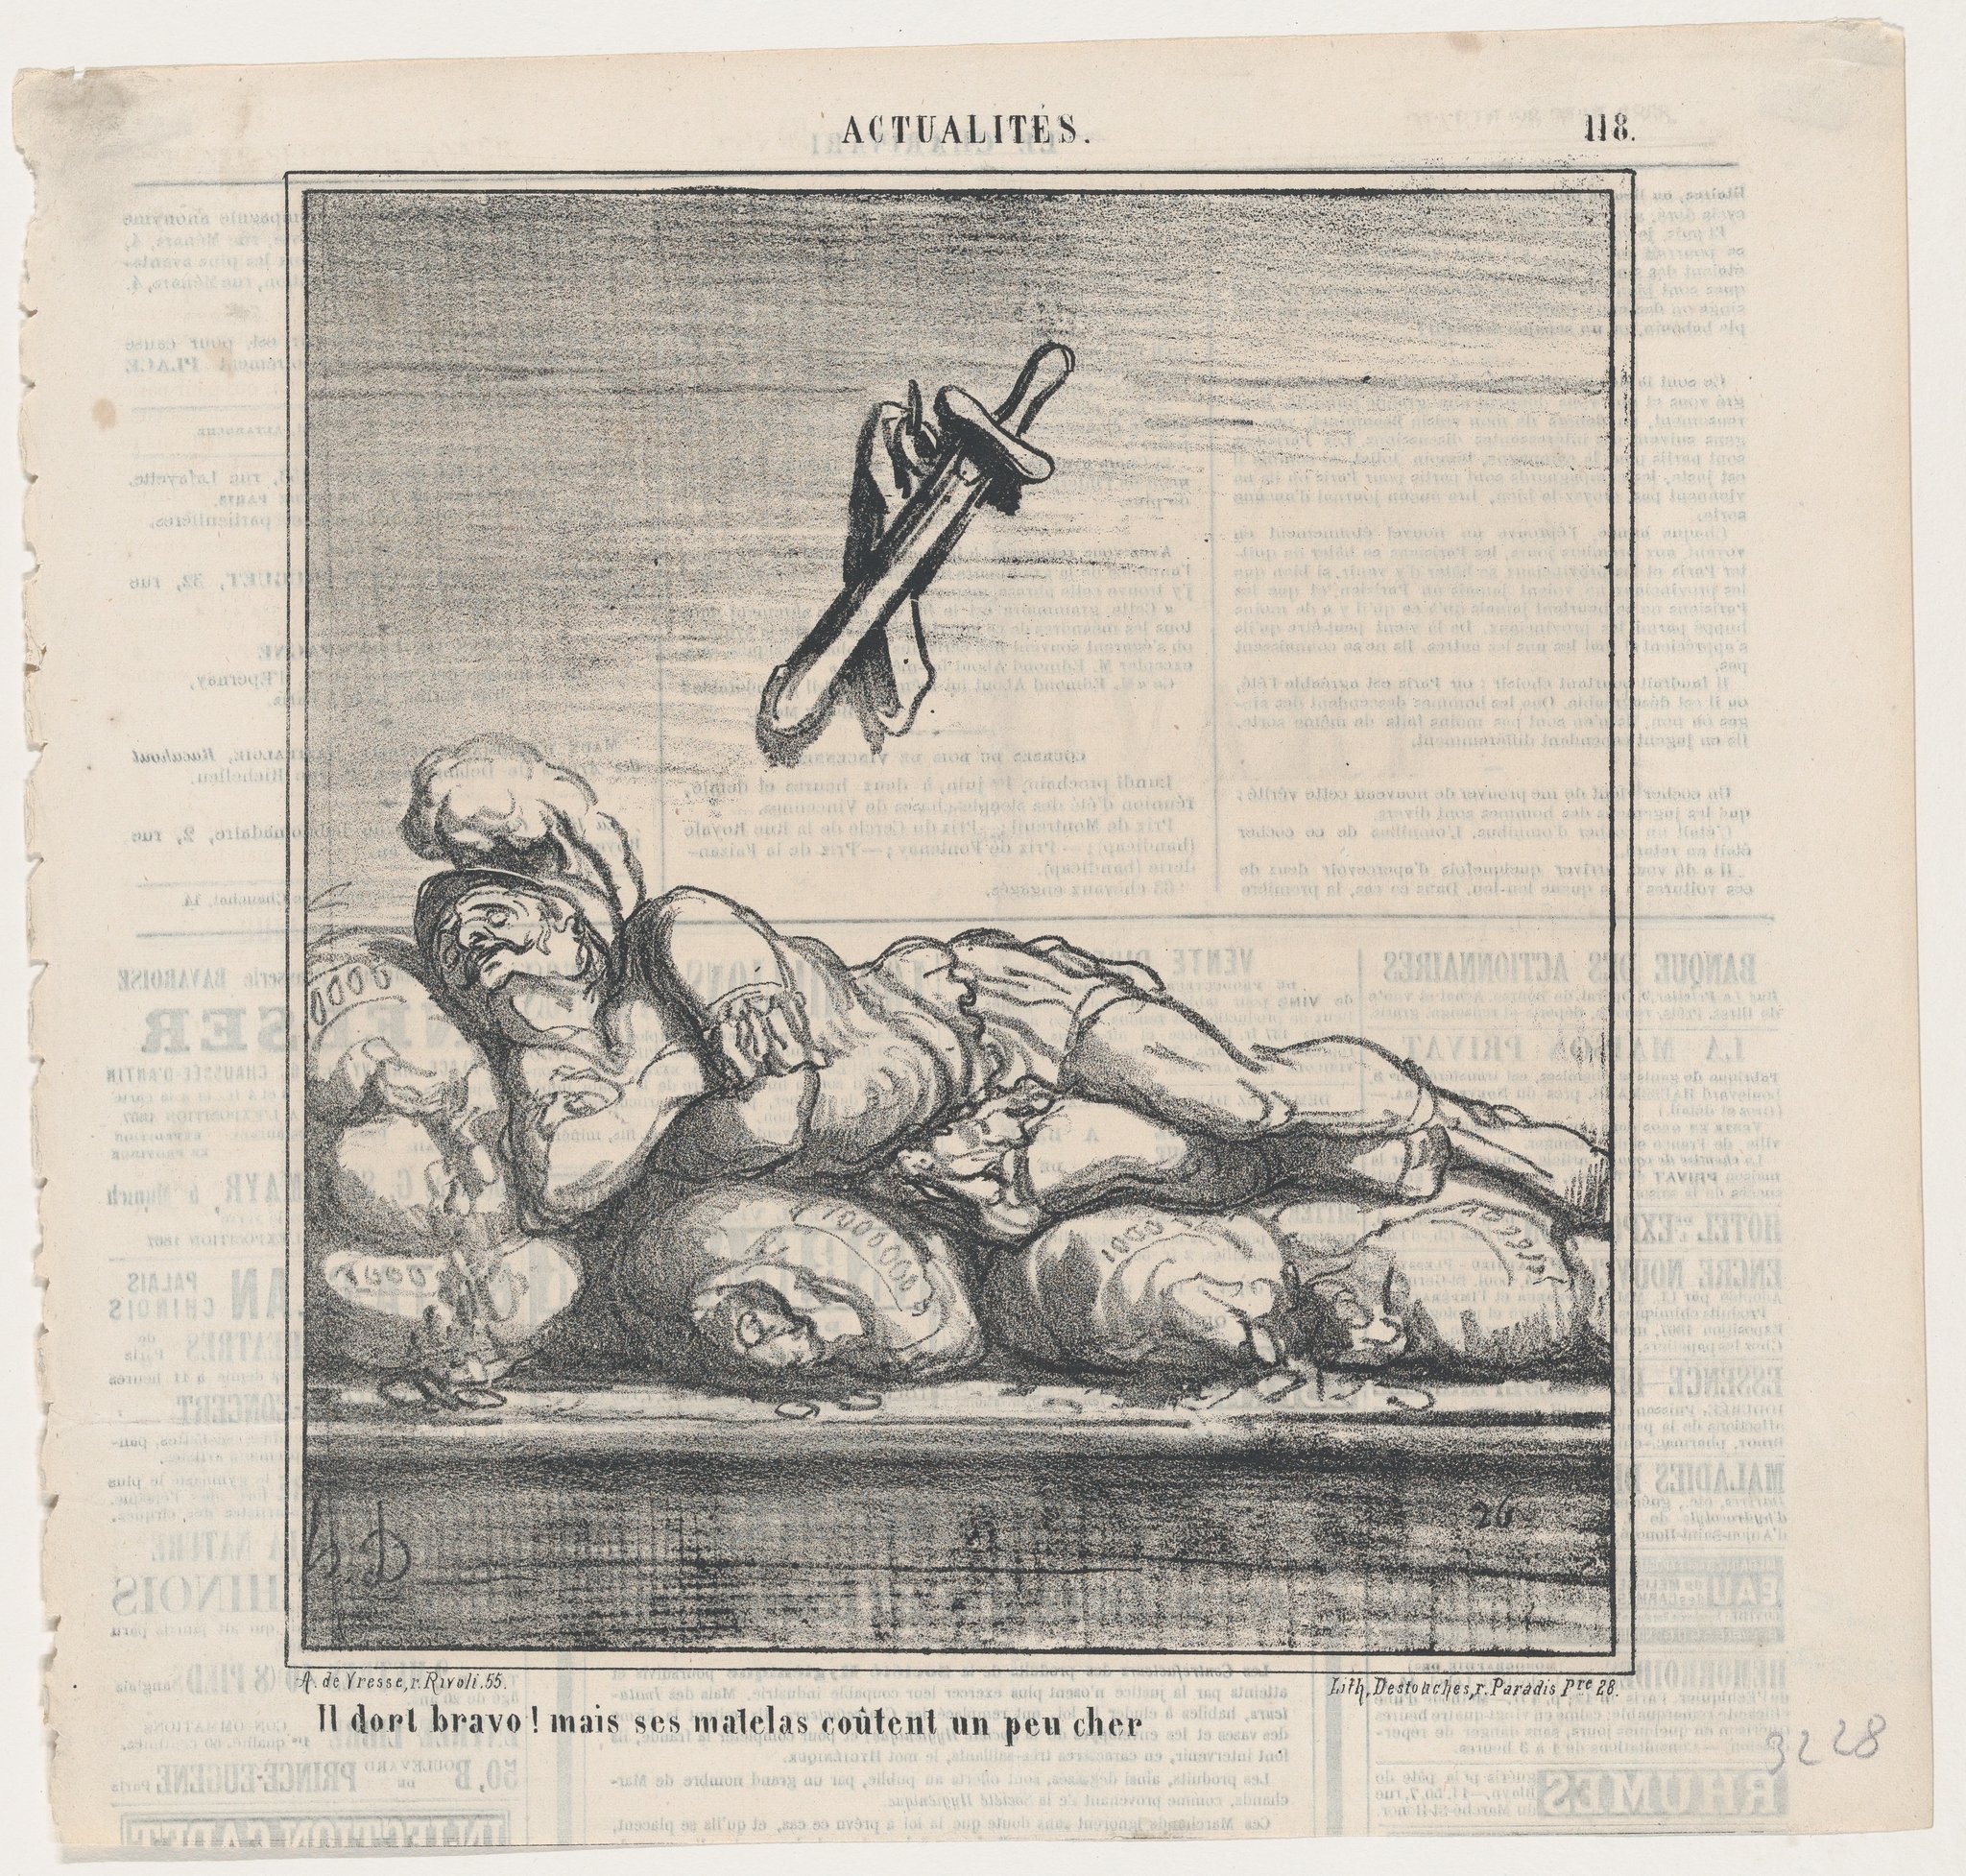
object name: print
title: Bravo, he is asleep, but his mattress is a bit expensive, from "News of the day"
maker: honoré daumier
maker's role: artist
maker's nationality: french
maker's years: 1808-1879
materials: paper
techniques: lithograph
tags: sleeping,men